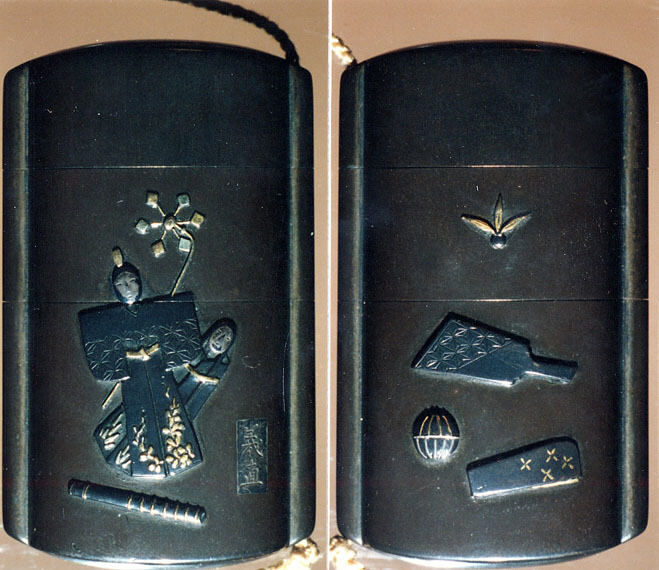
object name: inrō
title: Case (Inrō) with Symbols of Girls' Festival (obverse); Emblems for New Year Festival (reverse)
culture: japanese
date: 1801-1900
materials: gold, lacquer, metal, silver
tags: women